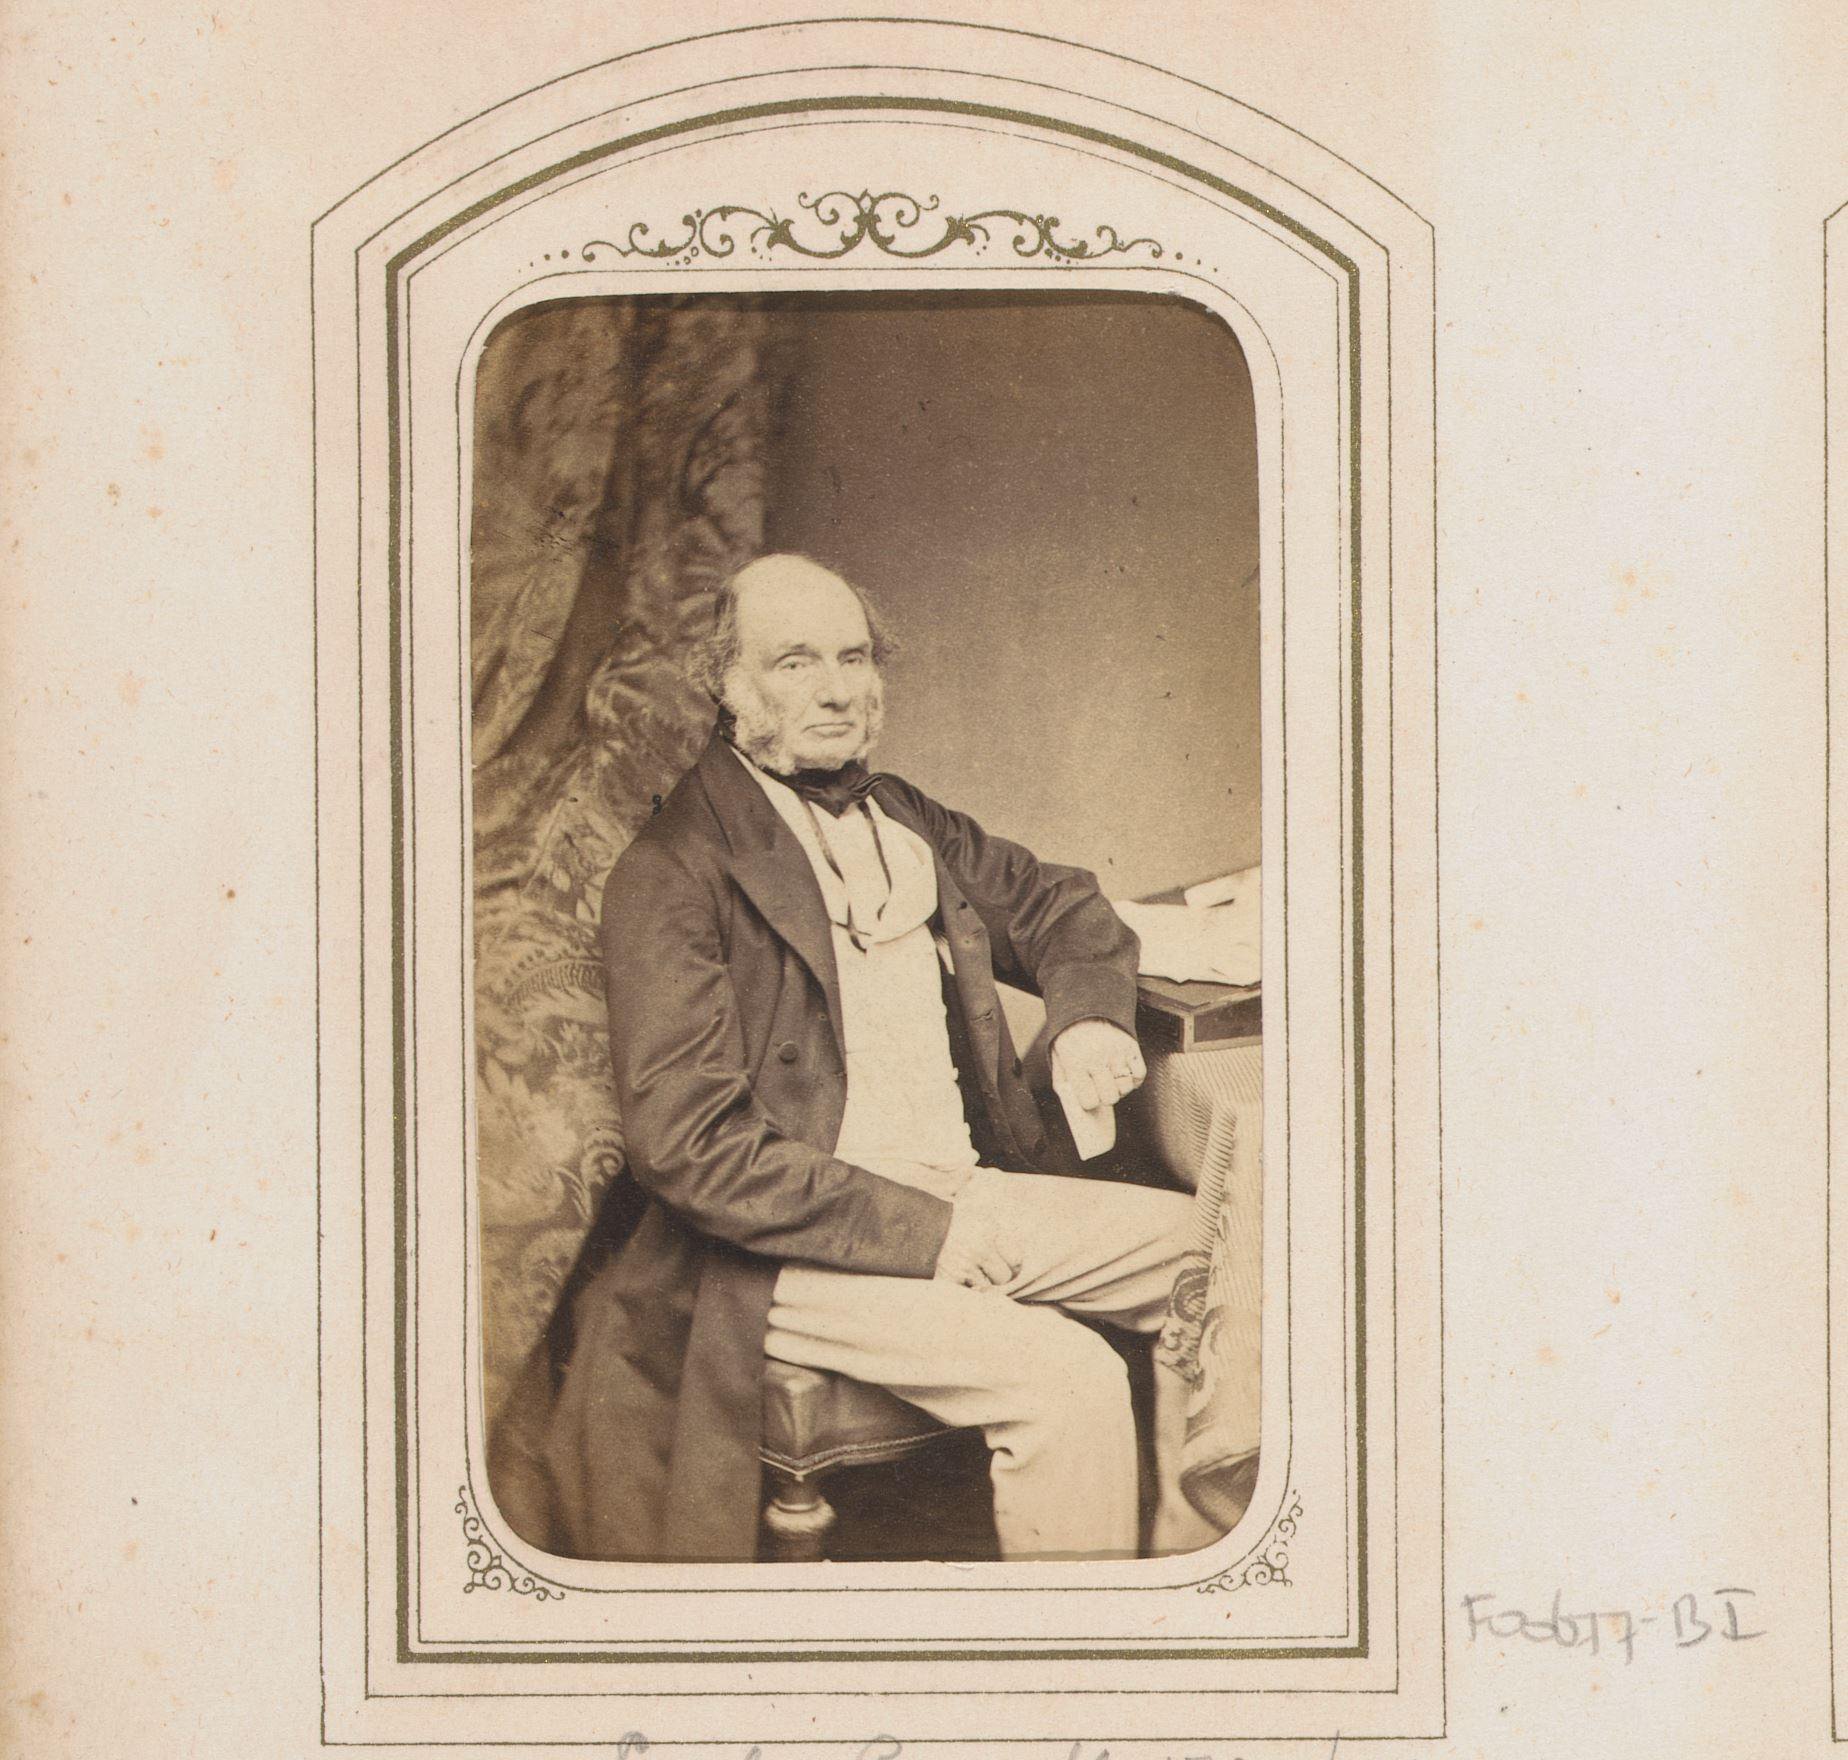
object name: carte de visite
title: Portret van John Russell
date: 1850-1860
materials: cardboard, photographic support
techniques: albumen print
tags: politician, historical persons, politician, e.g. party leader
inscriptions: annotation: ‘Earl Russell 1792/1878/ Eng minister pres 1846-1852 en/ 1865-1866’, inscription: ‘W. WALKER & SONS. PHOTO:64, MARGARET ST.CAVENDISH SQ: REGo.N 25&26 VIC.C.68.’, name: ‘Earl Russell’, inscription: ‘MESSrs W. WALKER & SONS./ Artists & Photographers./ 64, Margaret Street,/ CAVENDISH SQUARE.’